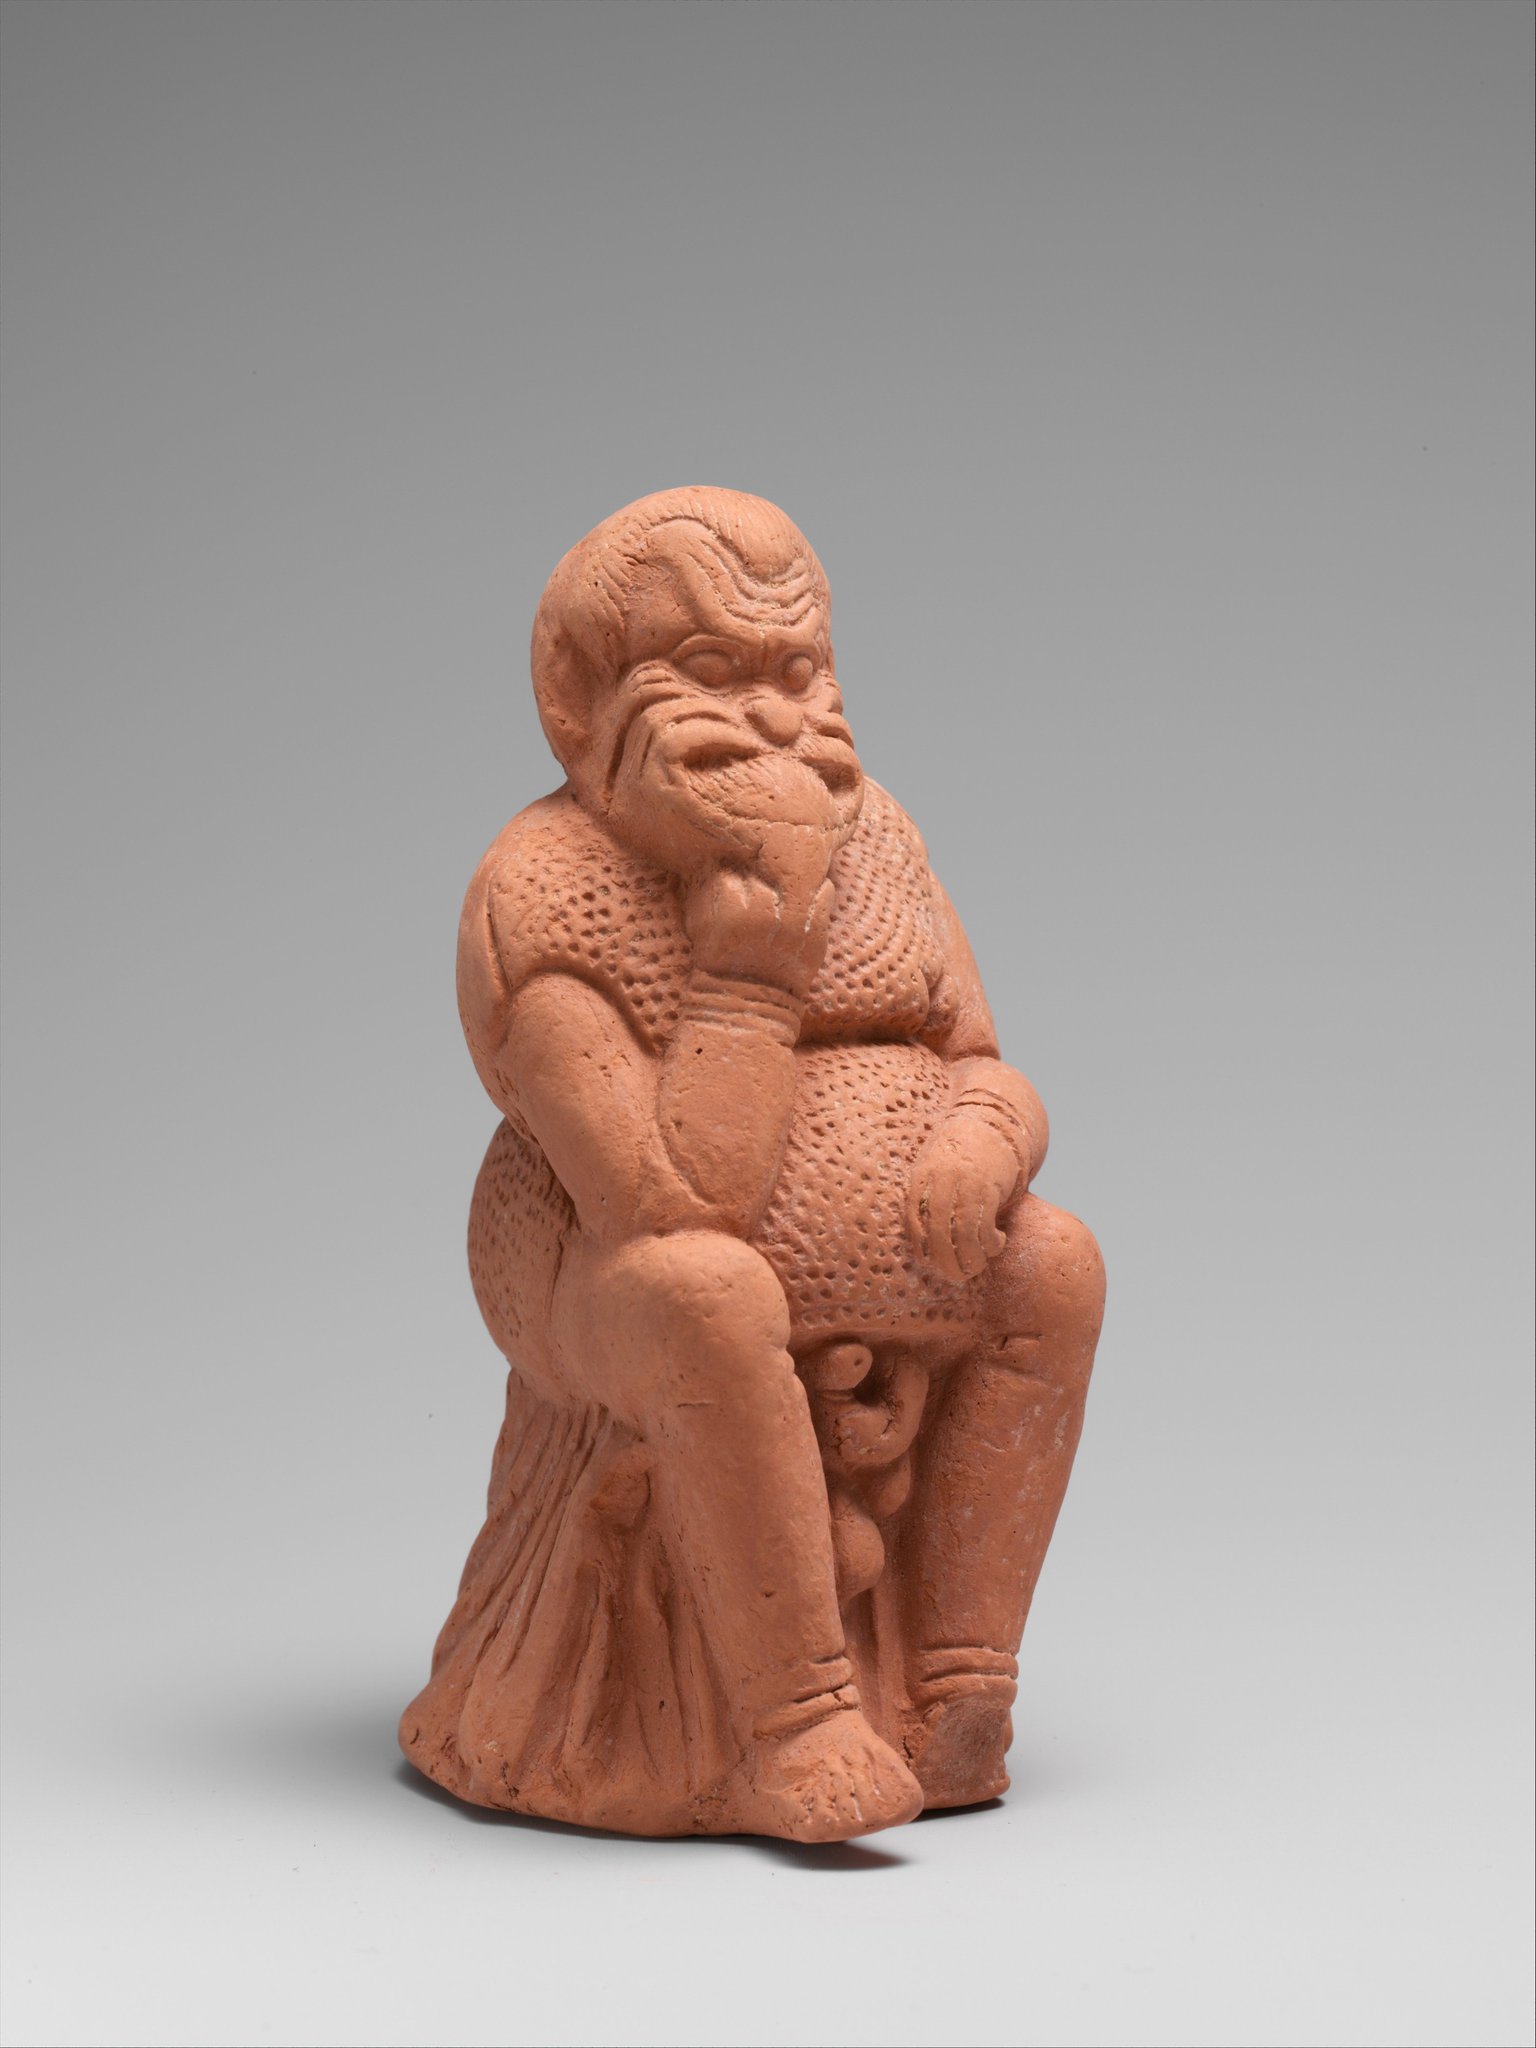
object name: statuette of an actor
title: Terracotta statuette of an actor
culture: greek, attic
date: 434-368 BCE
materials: terracotta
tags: men,actors